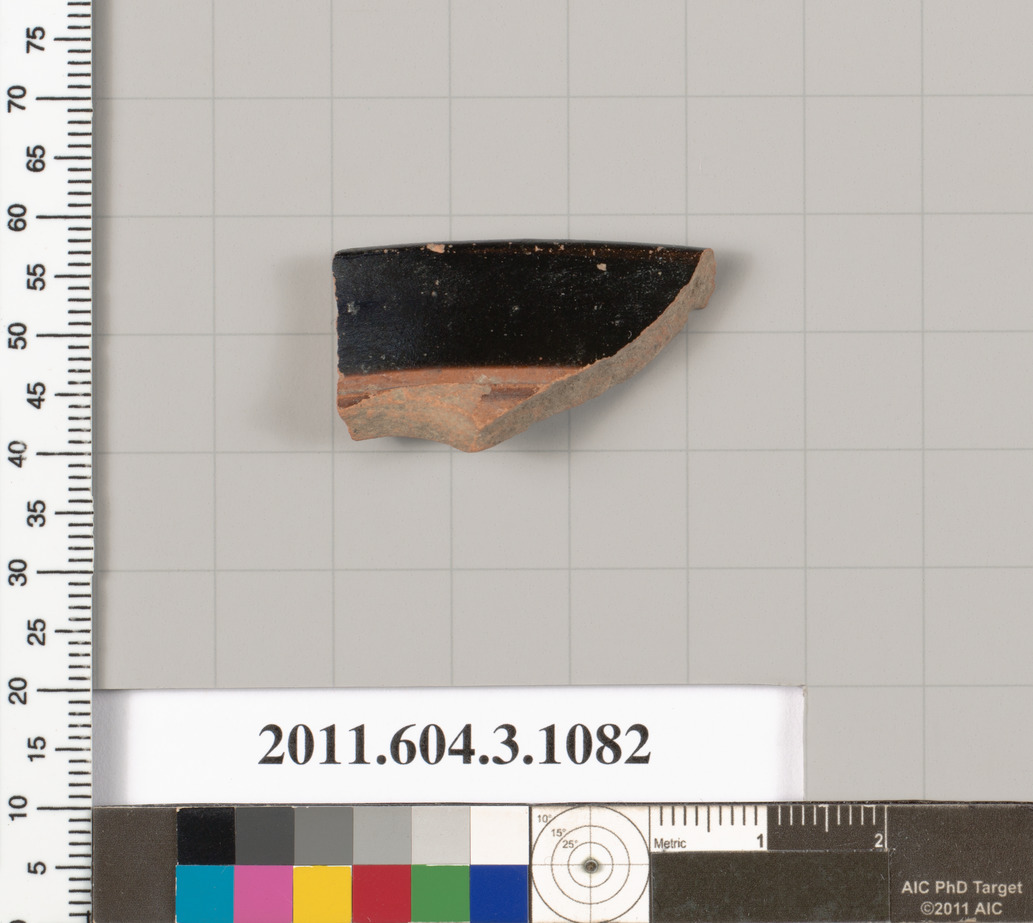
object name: mastoid fragment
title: Terracotta rim fragment of a mastoid (drinking cup with narrow base)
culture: greek, attic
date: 534-468 BCE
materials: terracotta